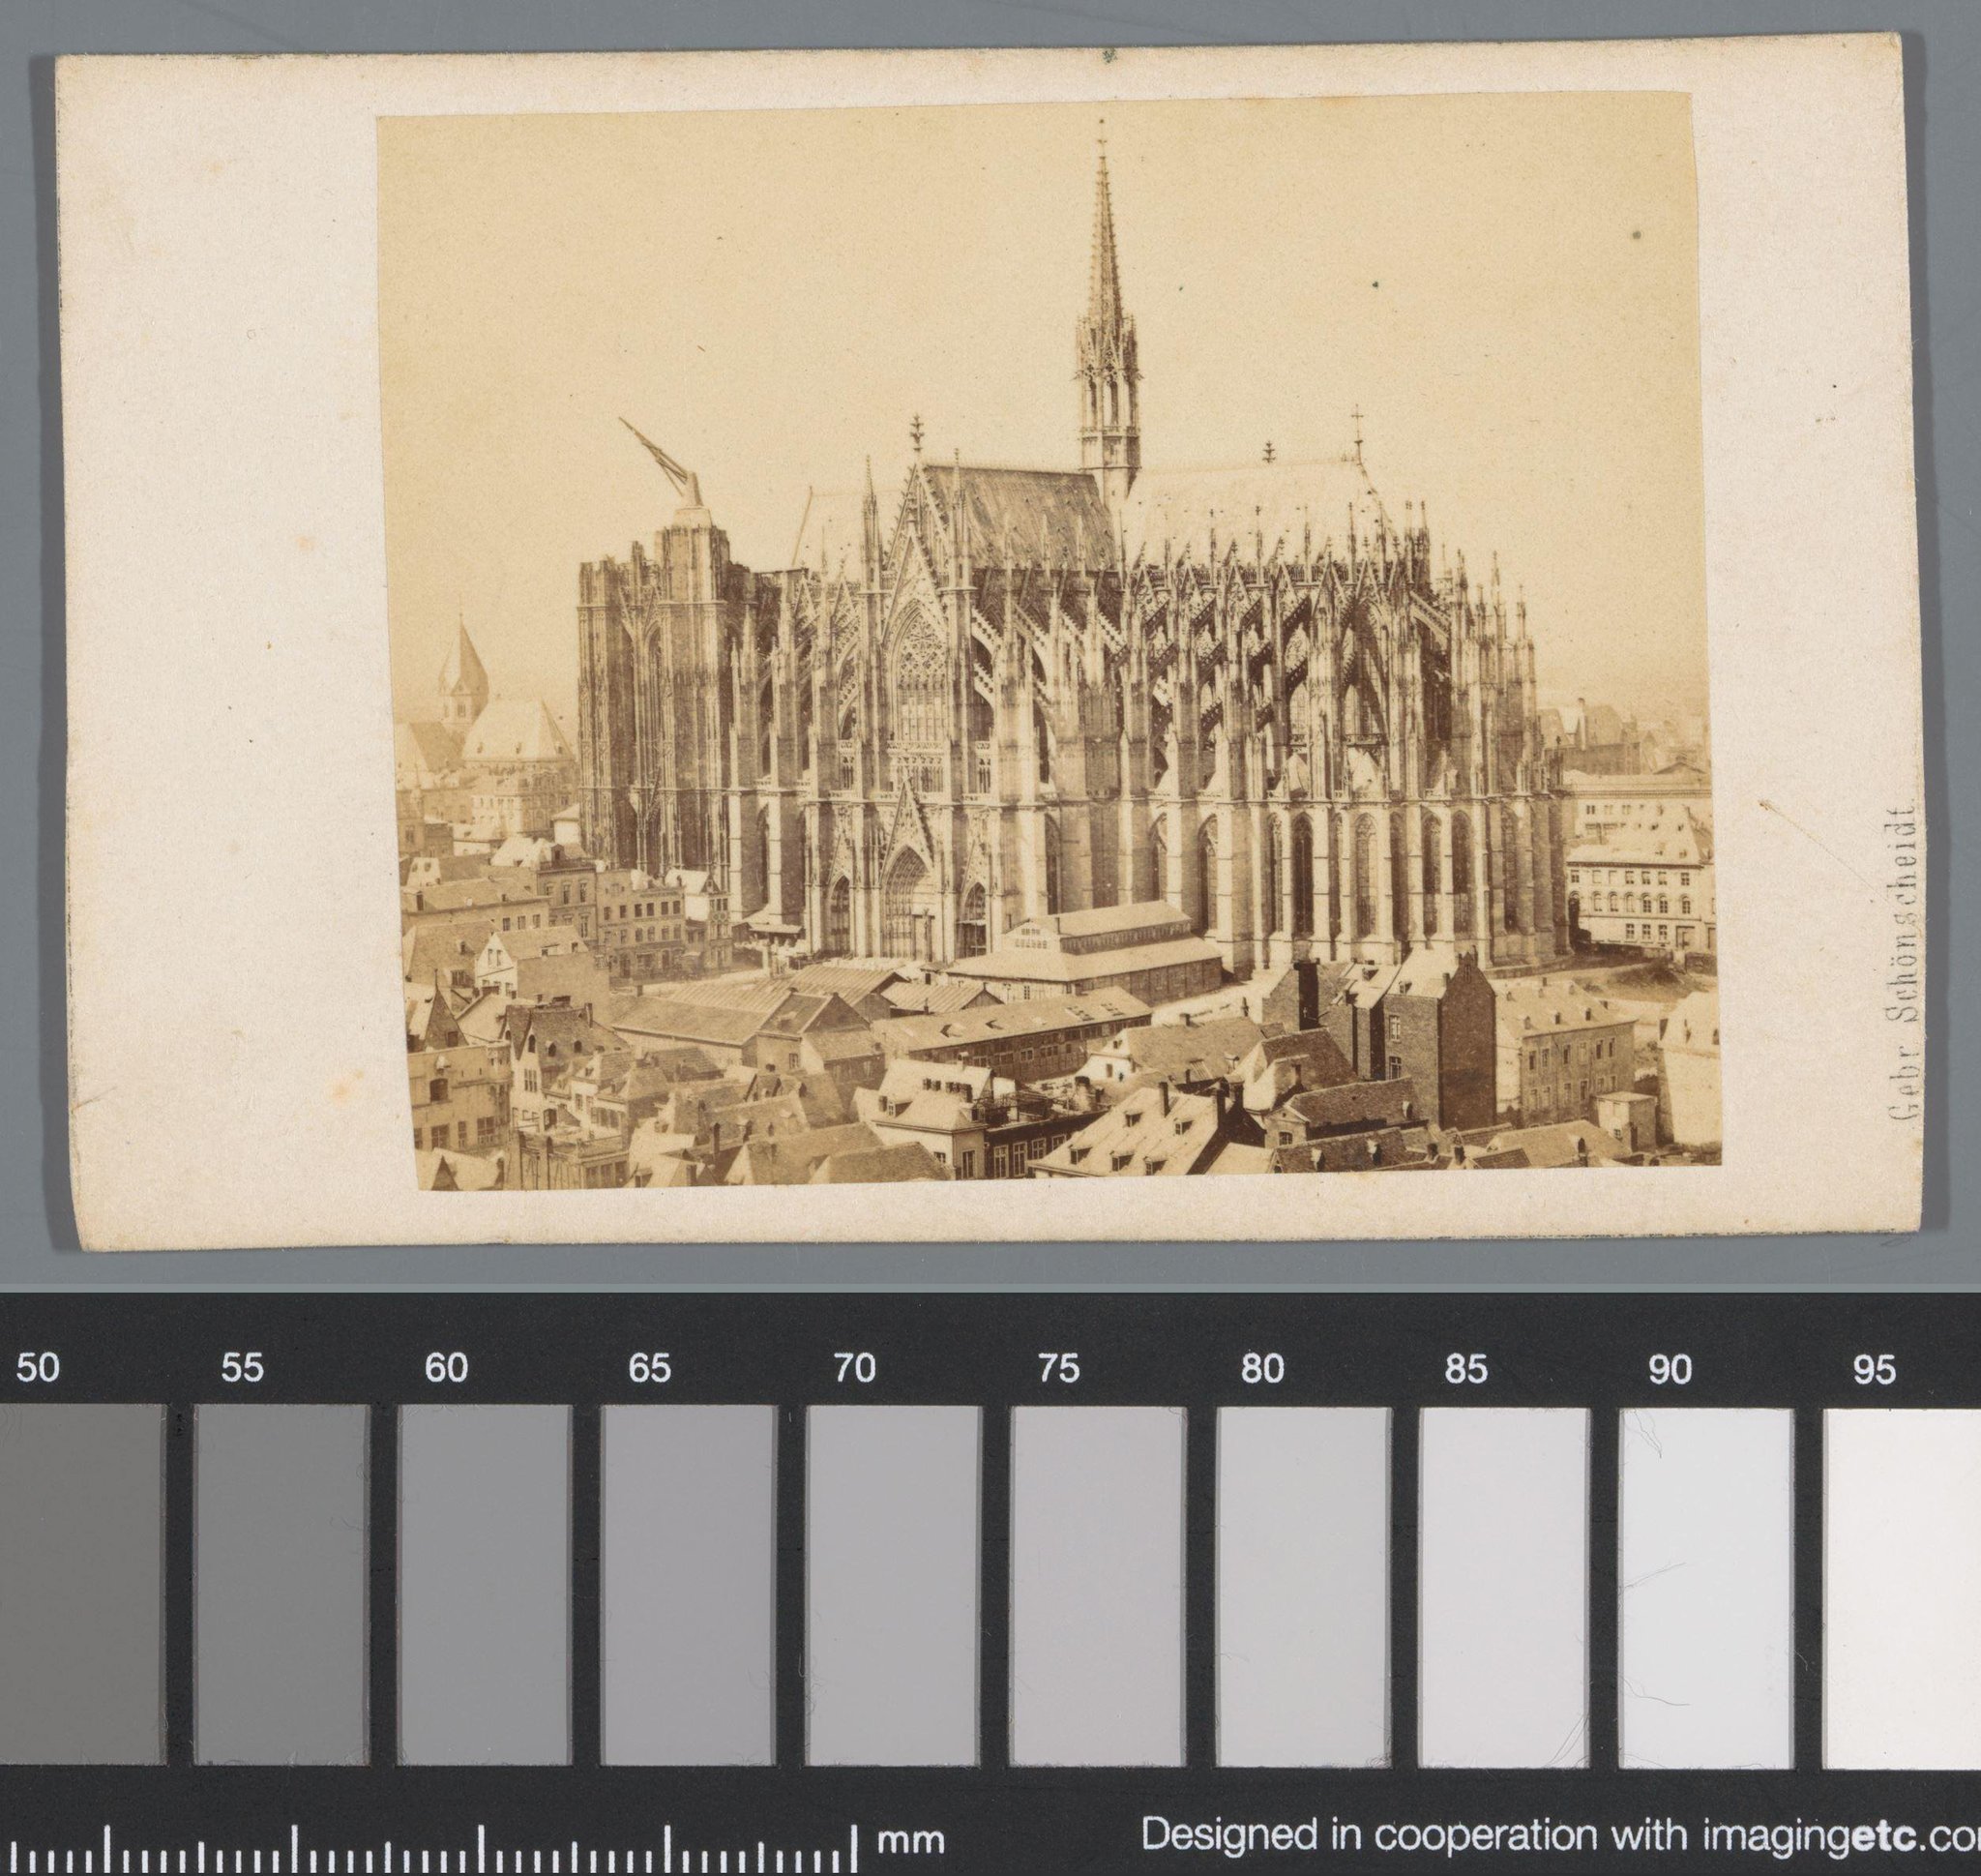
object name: carte de visite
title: Dom van Keulen in aanbouw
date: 1867-1868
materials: cardboard, paper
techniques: albumen print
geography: cologne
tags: church (exterior)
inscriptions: inscription: ‘Photographisches-Atelier/ von/ GEBRÜDER SCHÖNSCHEIDT/ in/ COELN a/R/ Schildergasse No. 85’